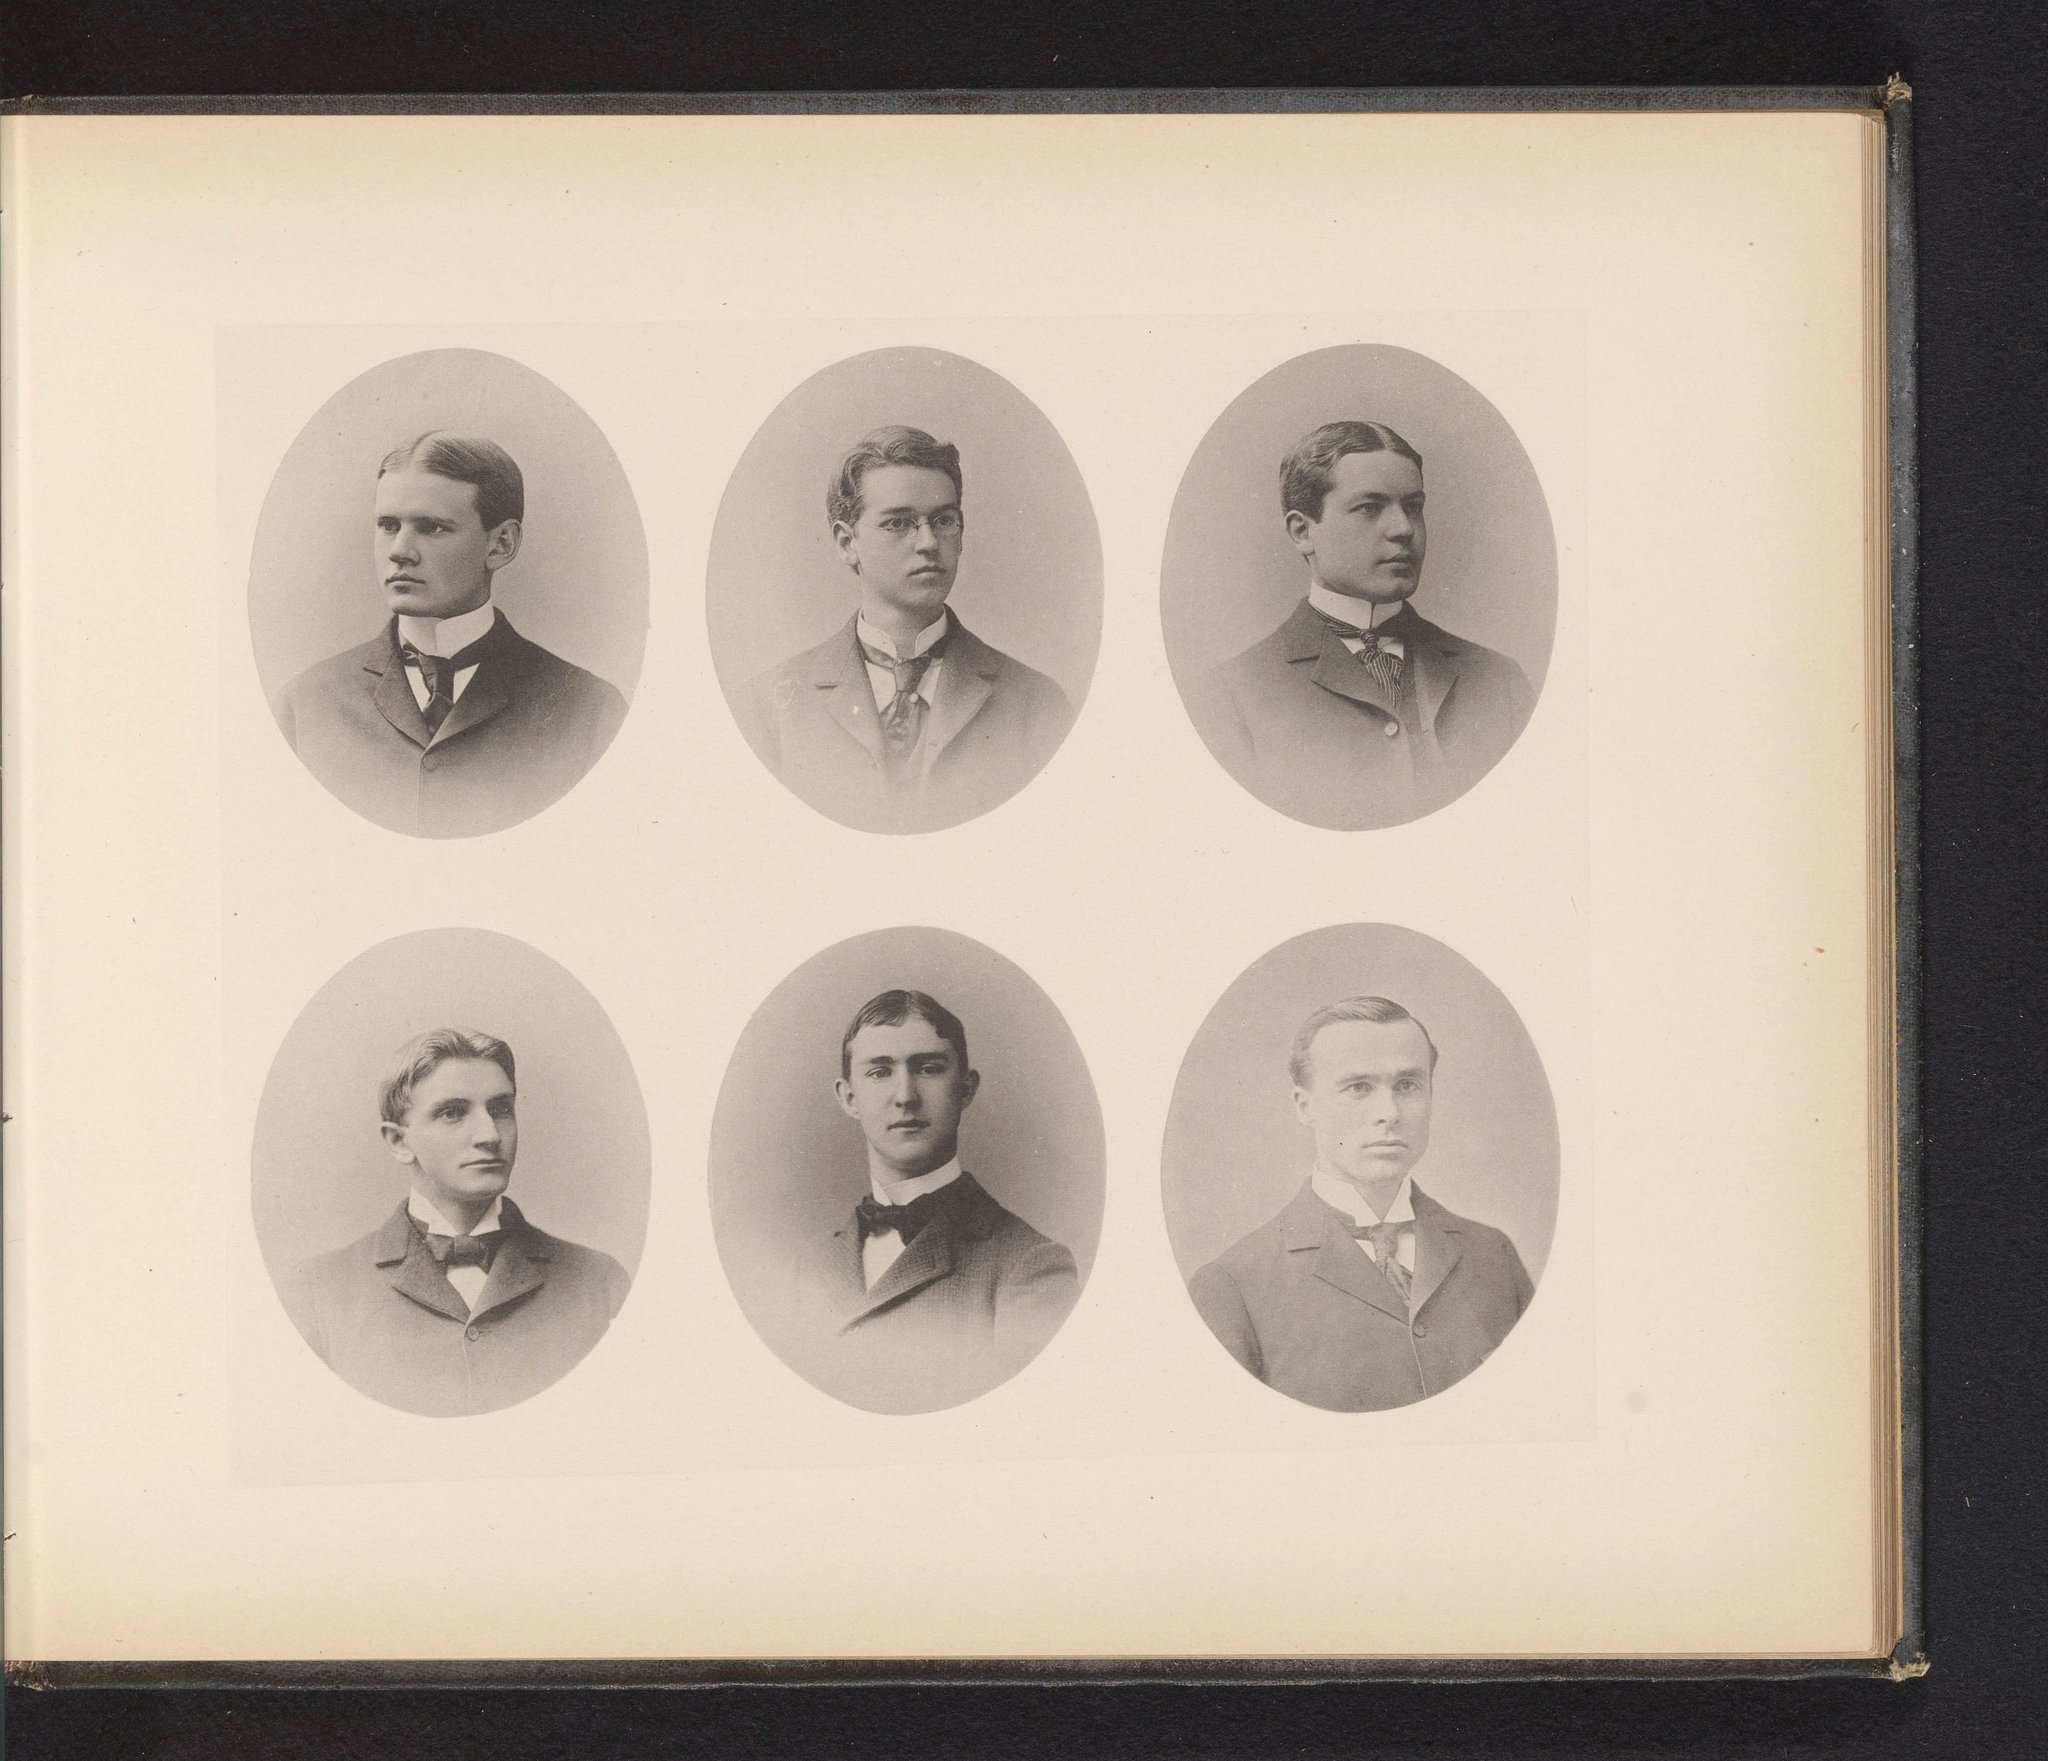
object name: page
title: Zes portretten van afgestudeerde studenten van Yale University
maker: Anonymous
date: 1895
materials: paper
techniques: photograph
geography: new york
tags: student